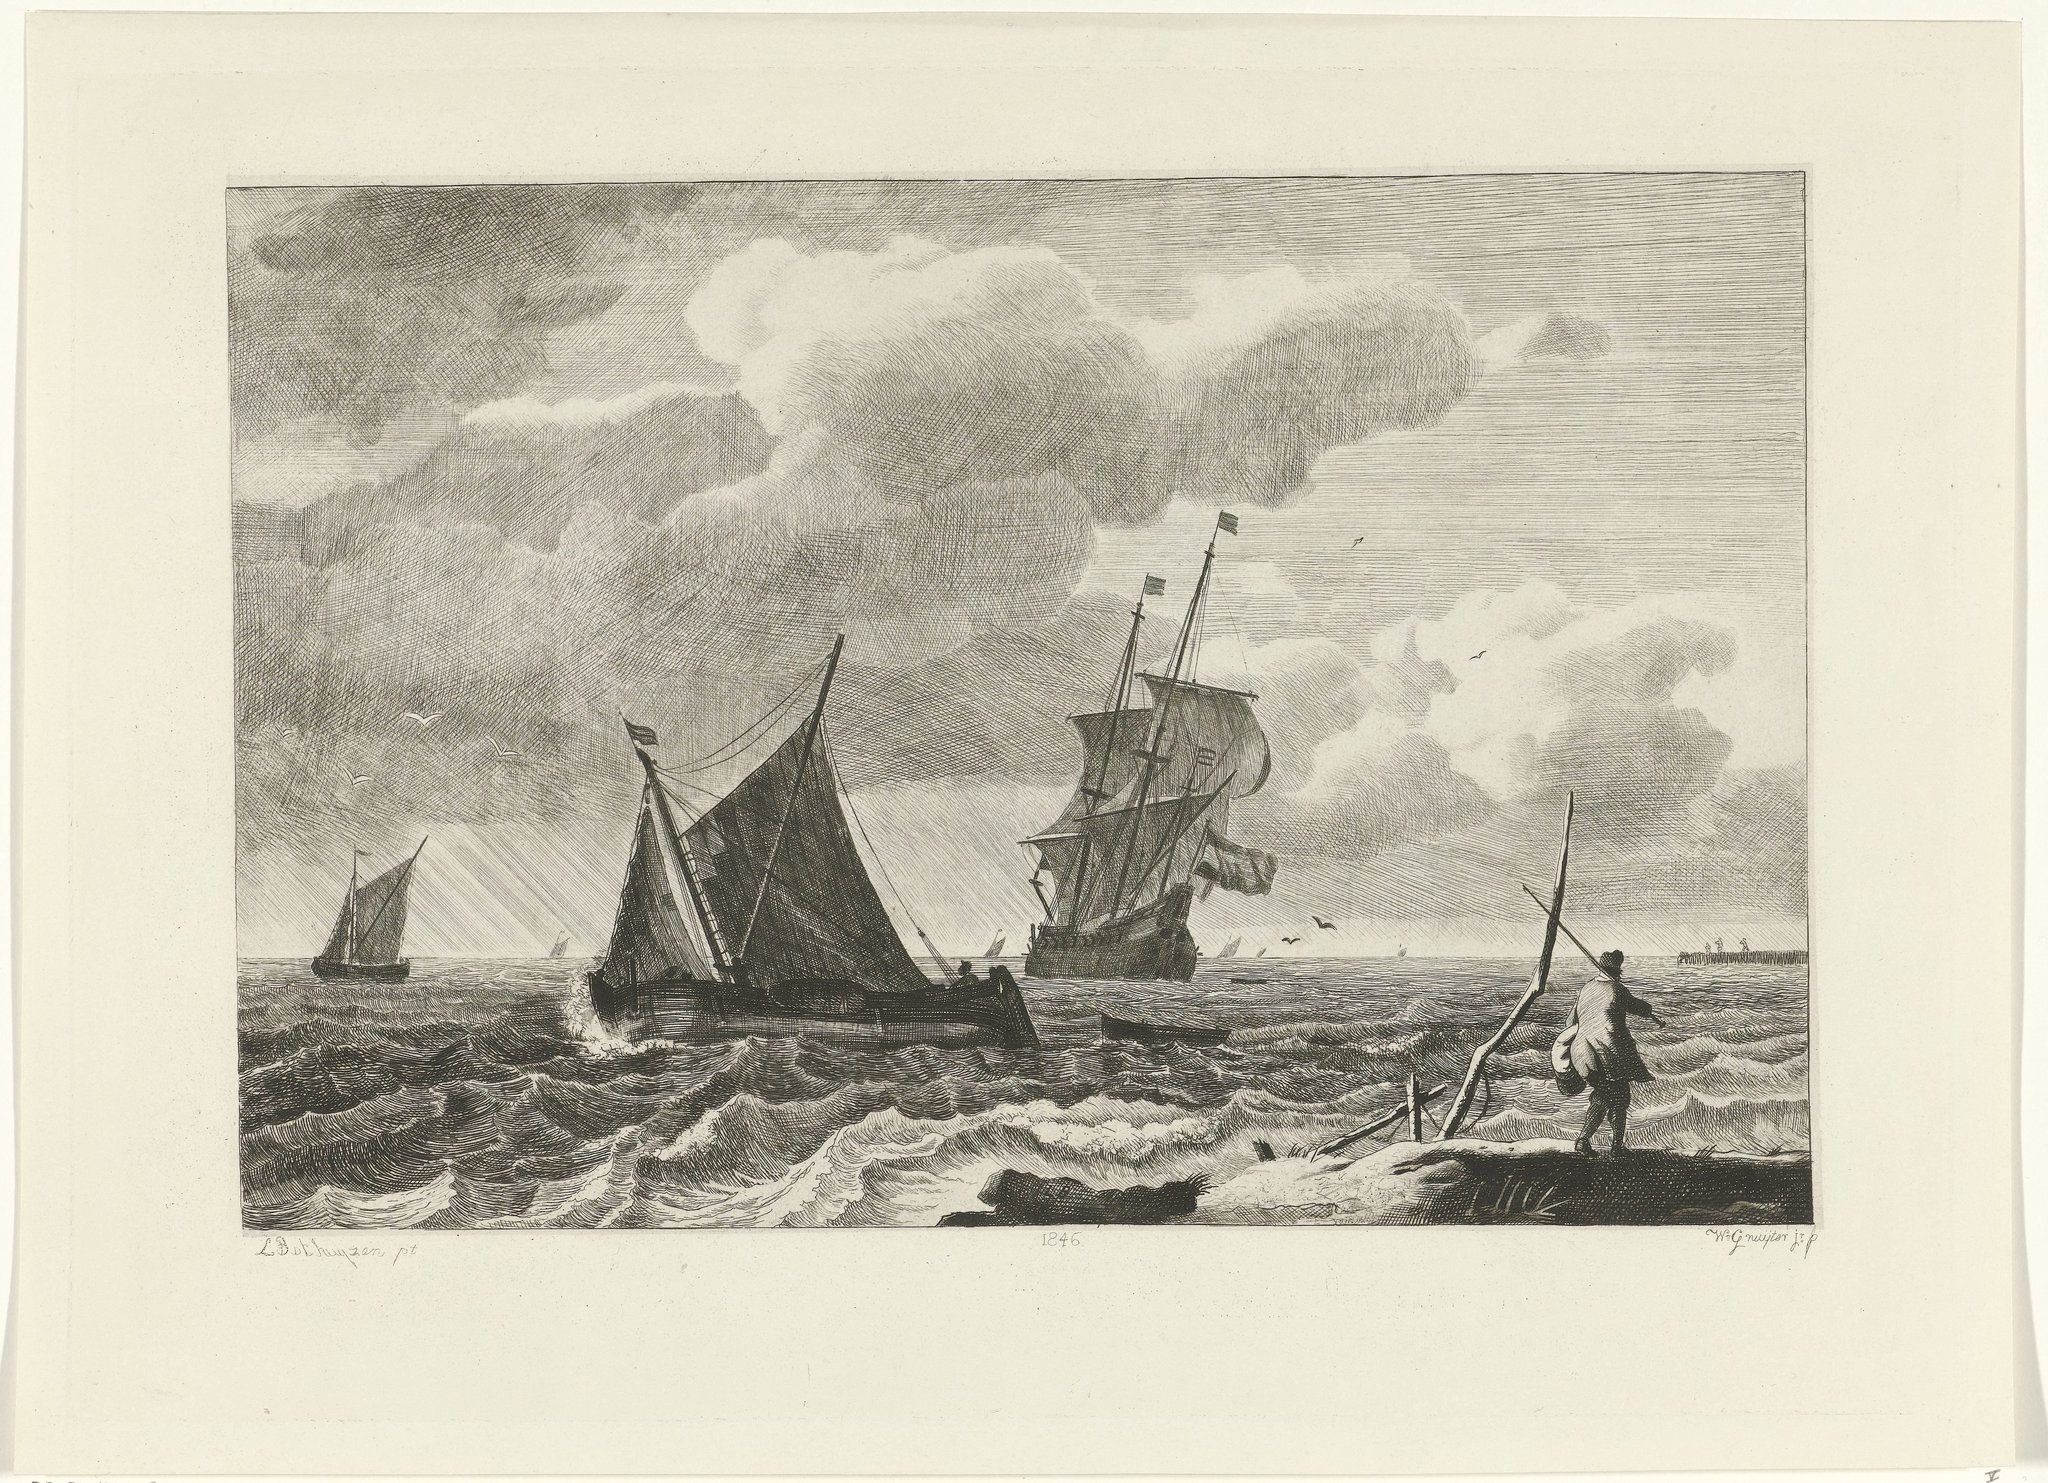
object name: print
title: Zeegezicht met zeilschepen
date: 1846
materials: paper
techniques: engraving, etching, roulette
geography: amsterdam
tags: sailing-ship, sailing-boat (+ view ~ vehicle, ship, etc.)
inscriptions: collector's mark: Lugt 2165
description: Zeegezicht met enkele zeilschepen, waaronder een tweemaster, bij sterke wind. Rechts op de voorgrond een man met een stok over zijn schouder. Op rots middenvoor staan de initialen van de schilder. Prent naar een schilderij van Ludolf Bakhuysen.